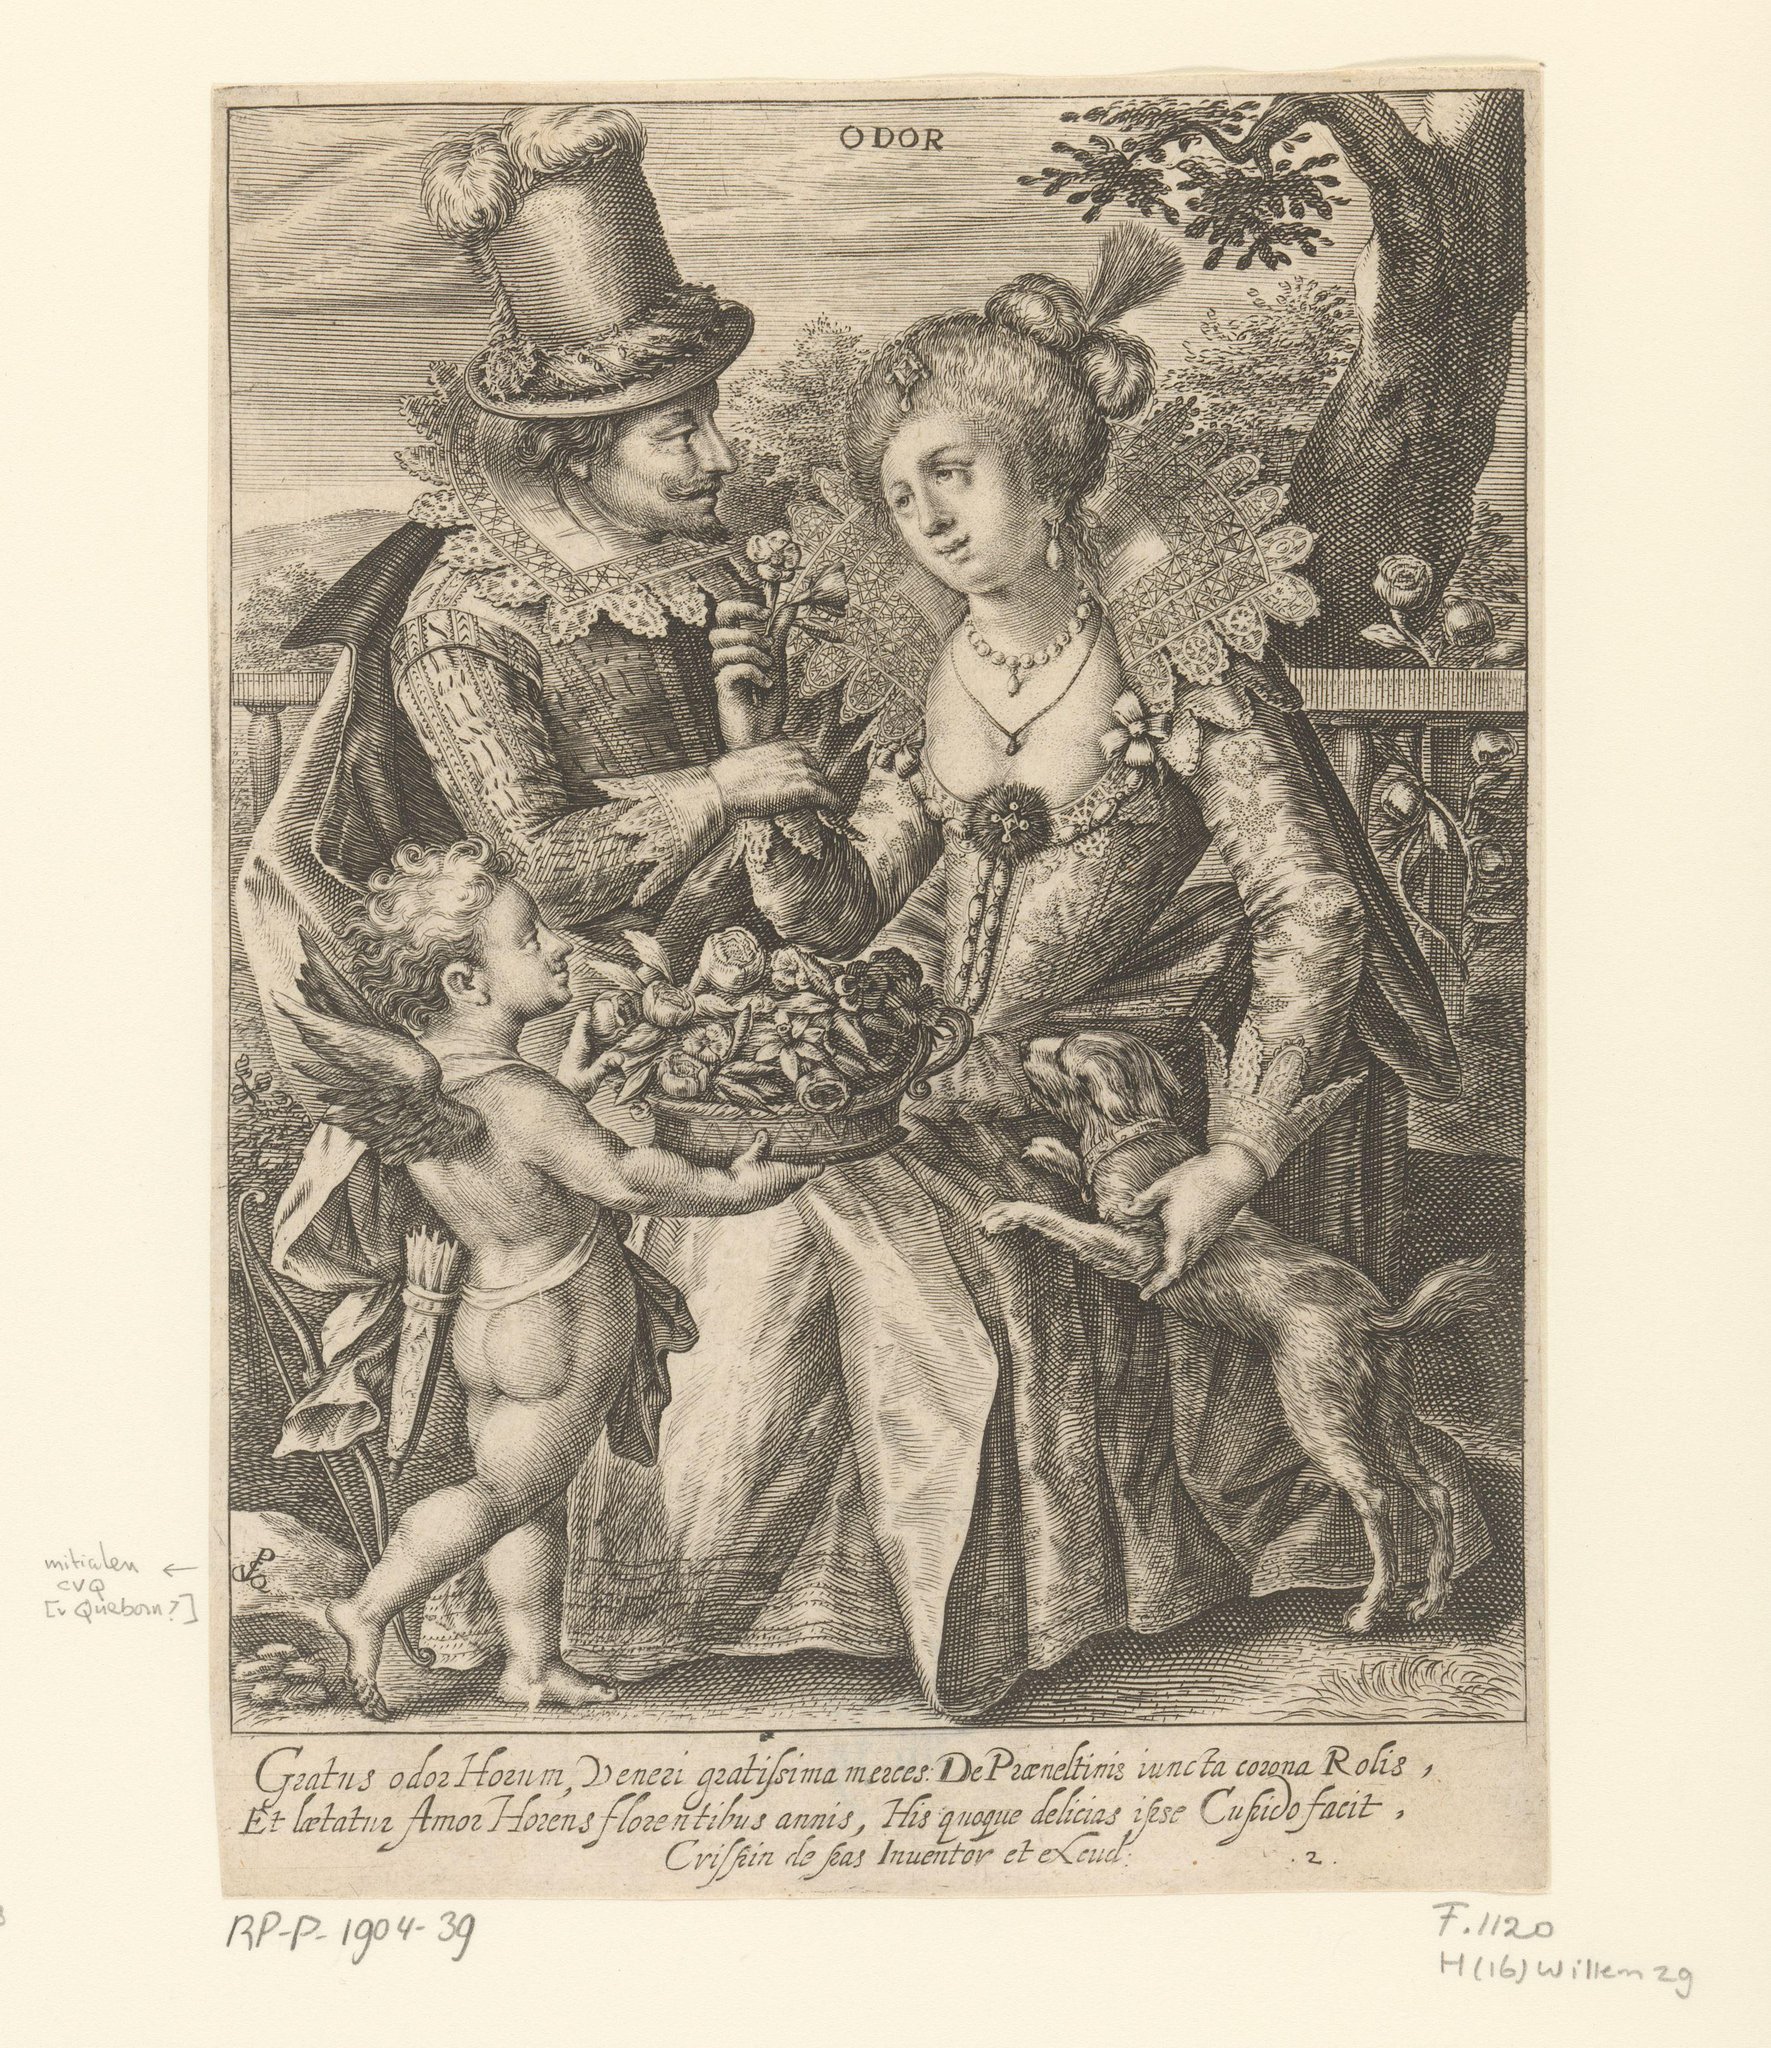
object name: print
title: Reuk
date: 1607-1637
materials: paper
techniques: engraving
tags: smell, smelling (one of the five senses), fettered cupid, 'amor cruciatus'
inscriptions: collector's mark: Lugt 2228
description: De personificatie van de Reuk. Een hond springt tegen haar op. Amor biedt haar een mand met rozen aan. Ze wordt vergezeld door een man. In de marge een tweeregelig onderschrift in het Latijn.